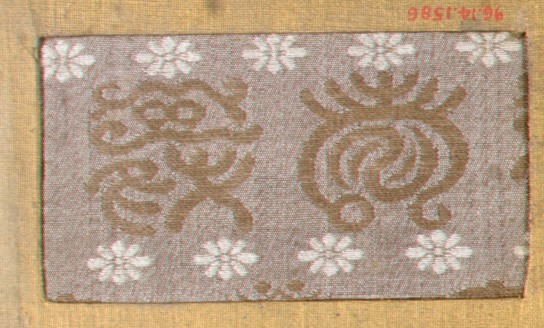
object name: piece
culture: japanese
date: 1701-1900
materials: silk